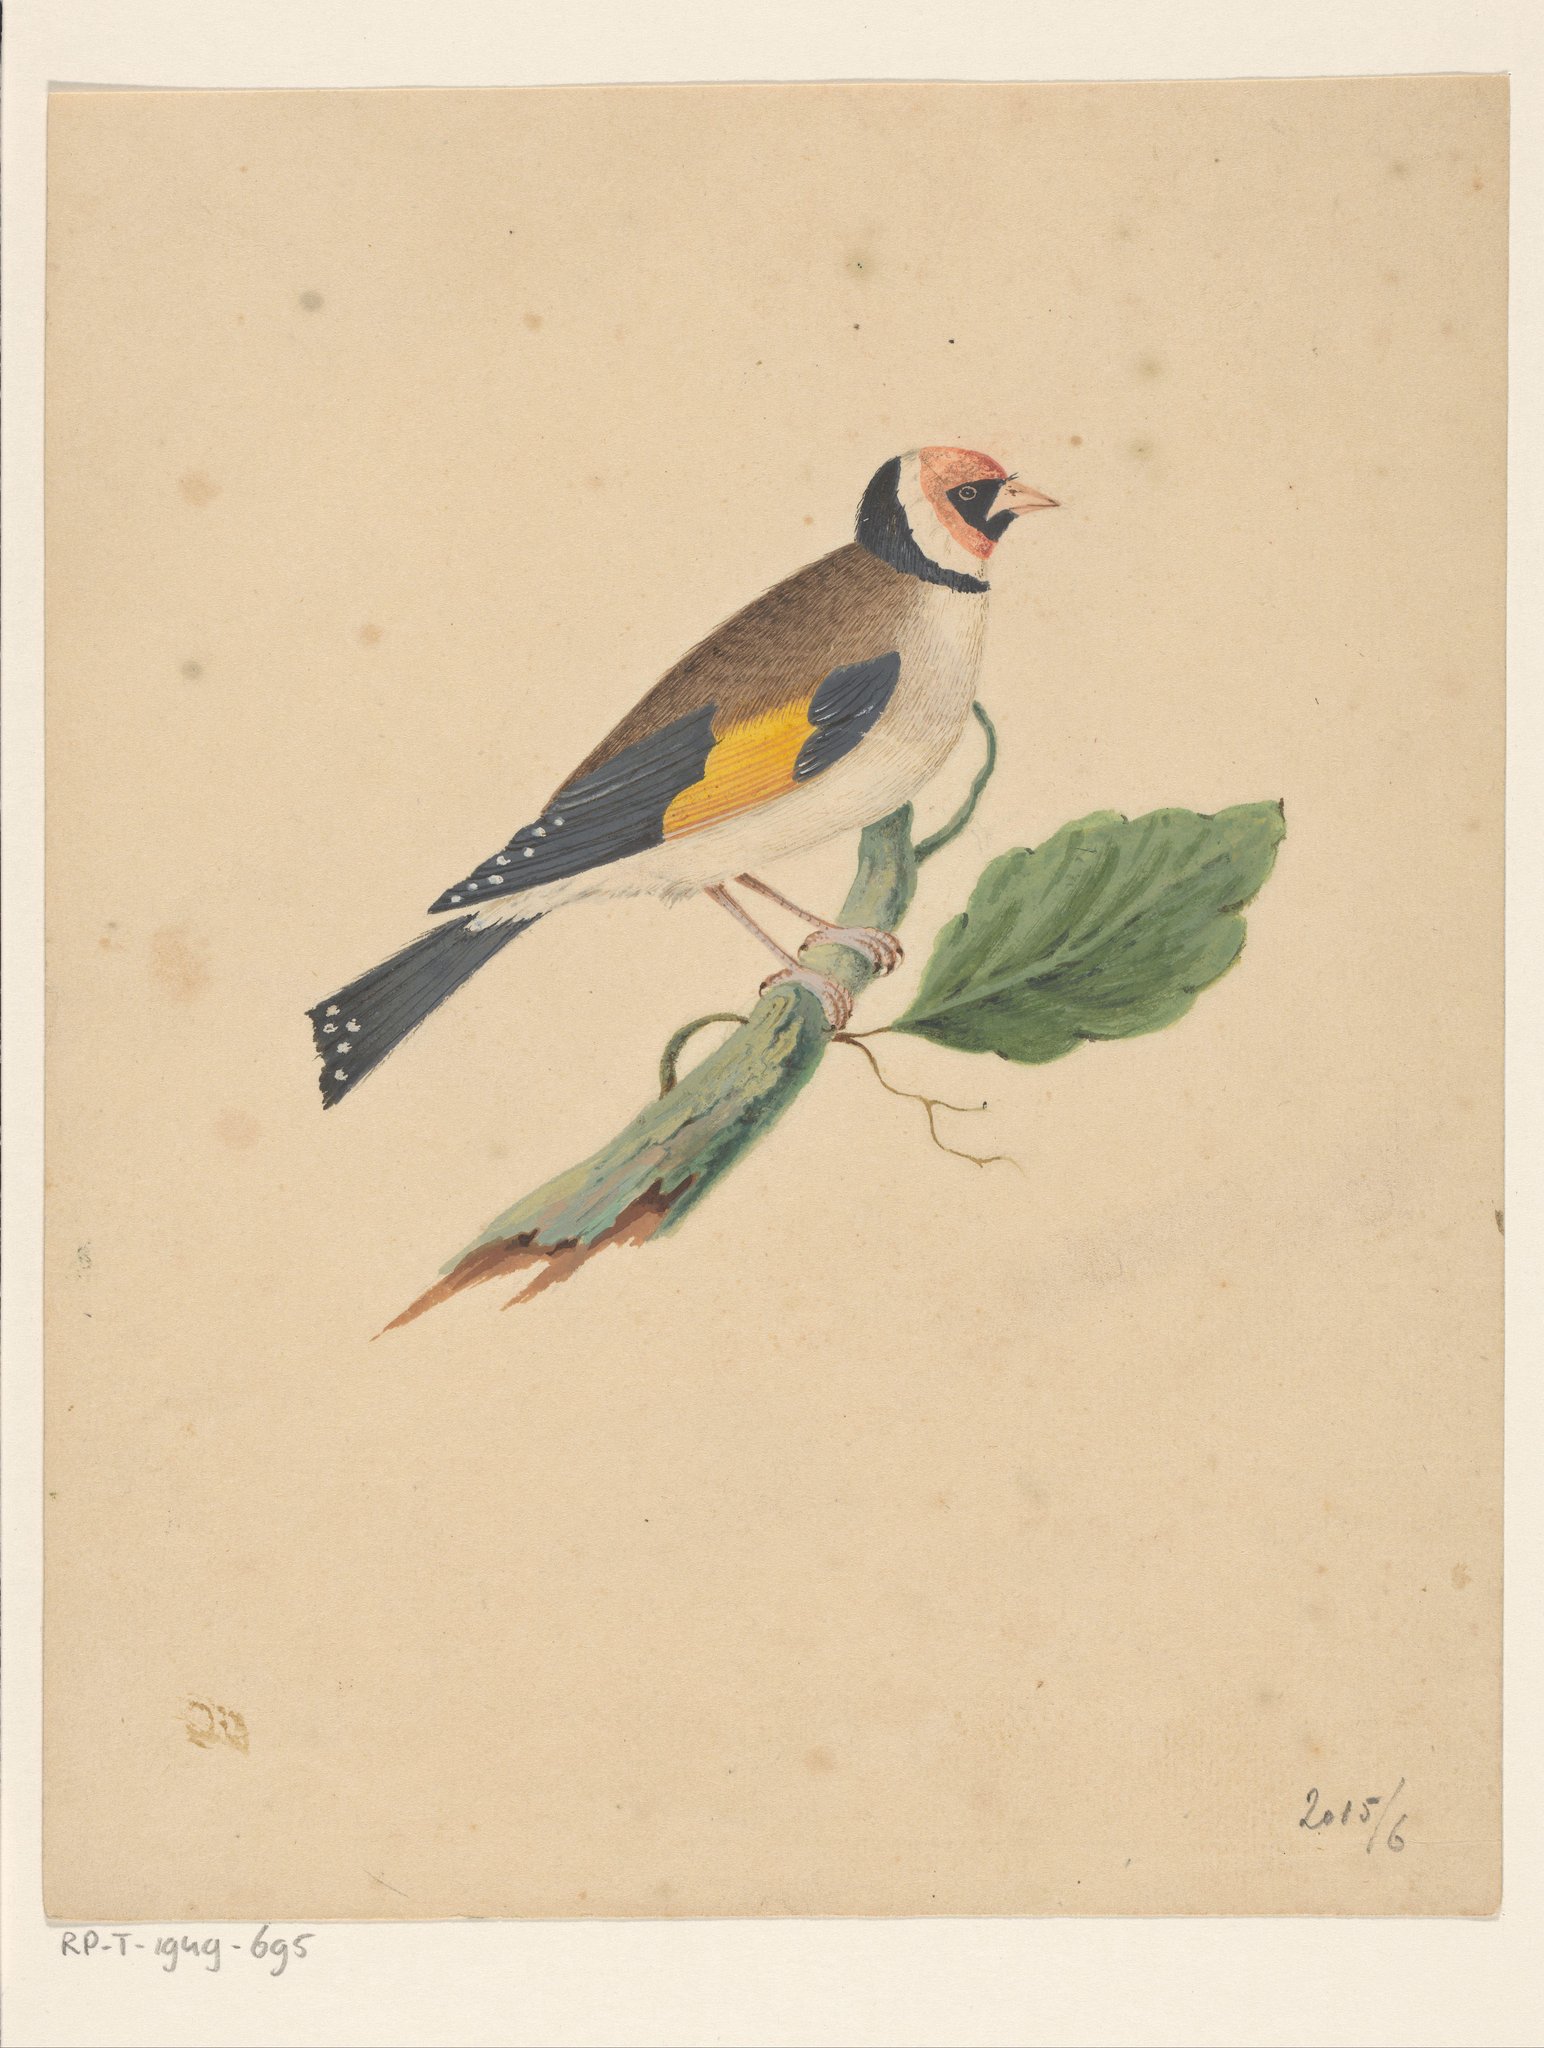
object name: watercolor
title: Goudvink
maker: Anonymous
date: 1700-1800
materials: paper, pencil, watercolor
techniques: brush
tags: song-birds: bullfinch